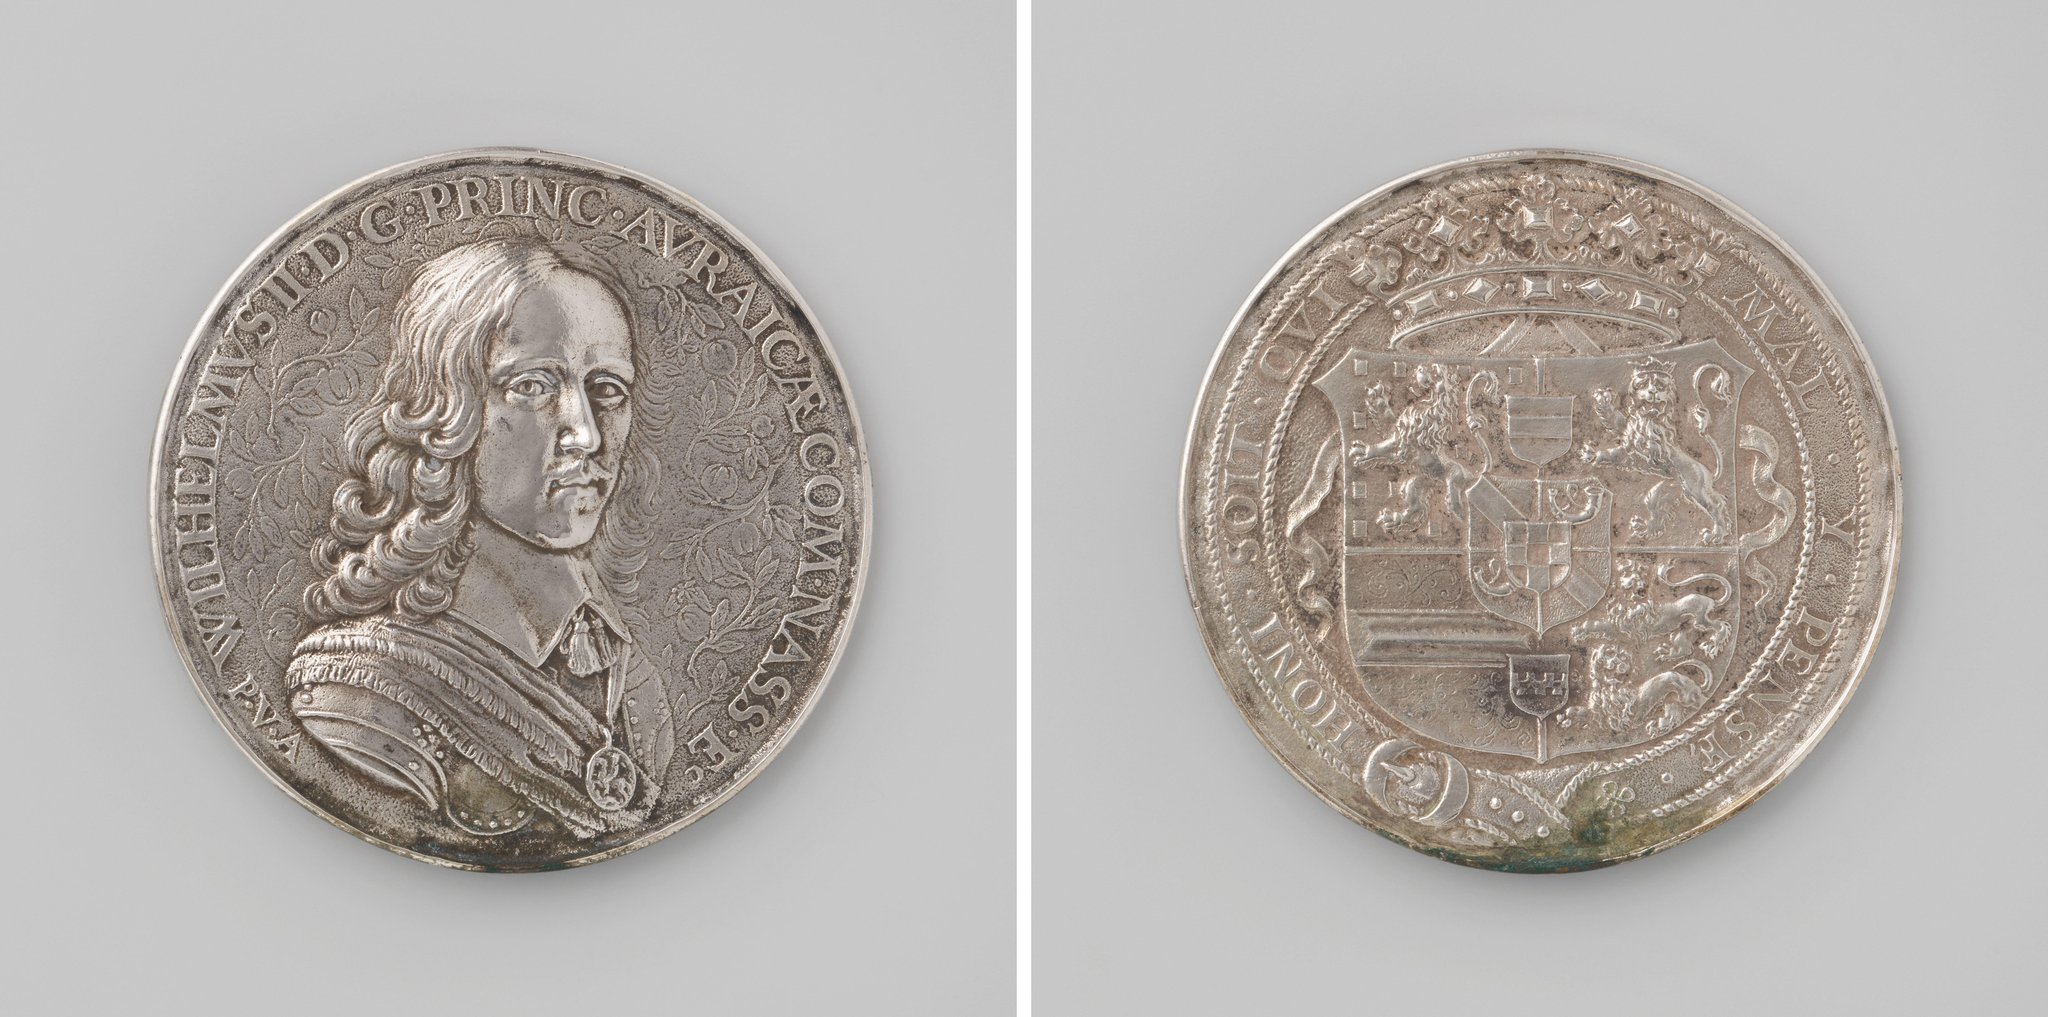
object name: honorary medal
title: Willem II, prins van Oranje-Nassau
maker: pieter van abeele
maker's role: draughtsman, jeweler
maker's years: 1608-1684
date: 1650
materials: silver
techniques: casting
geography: amsterdam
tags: william ii (prince of orange), amsterdam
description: Zilveren penning. Voorzijde: borststuk man binnen omschrift. Keerzijde: gekroond wapenschild binnen omschrift.